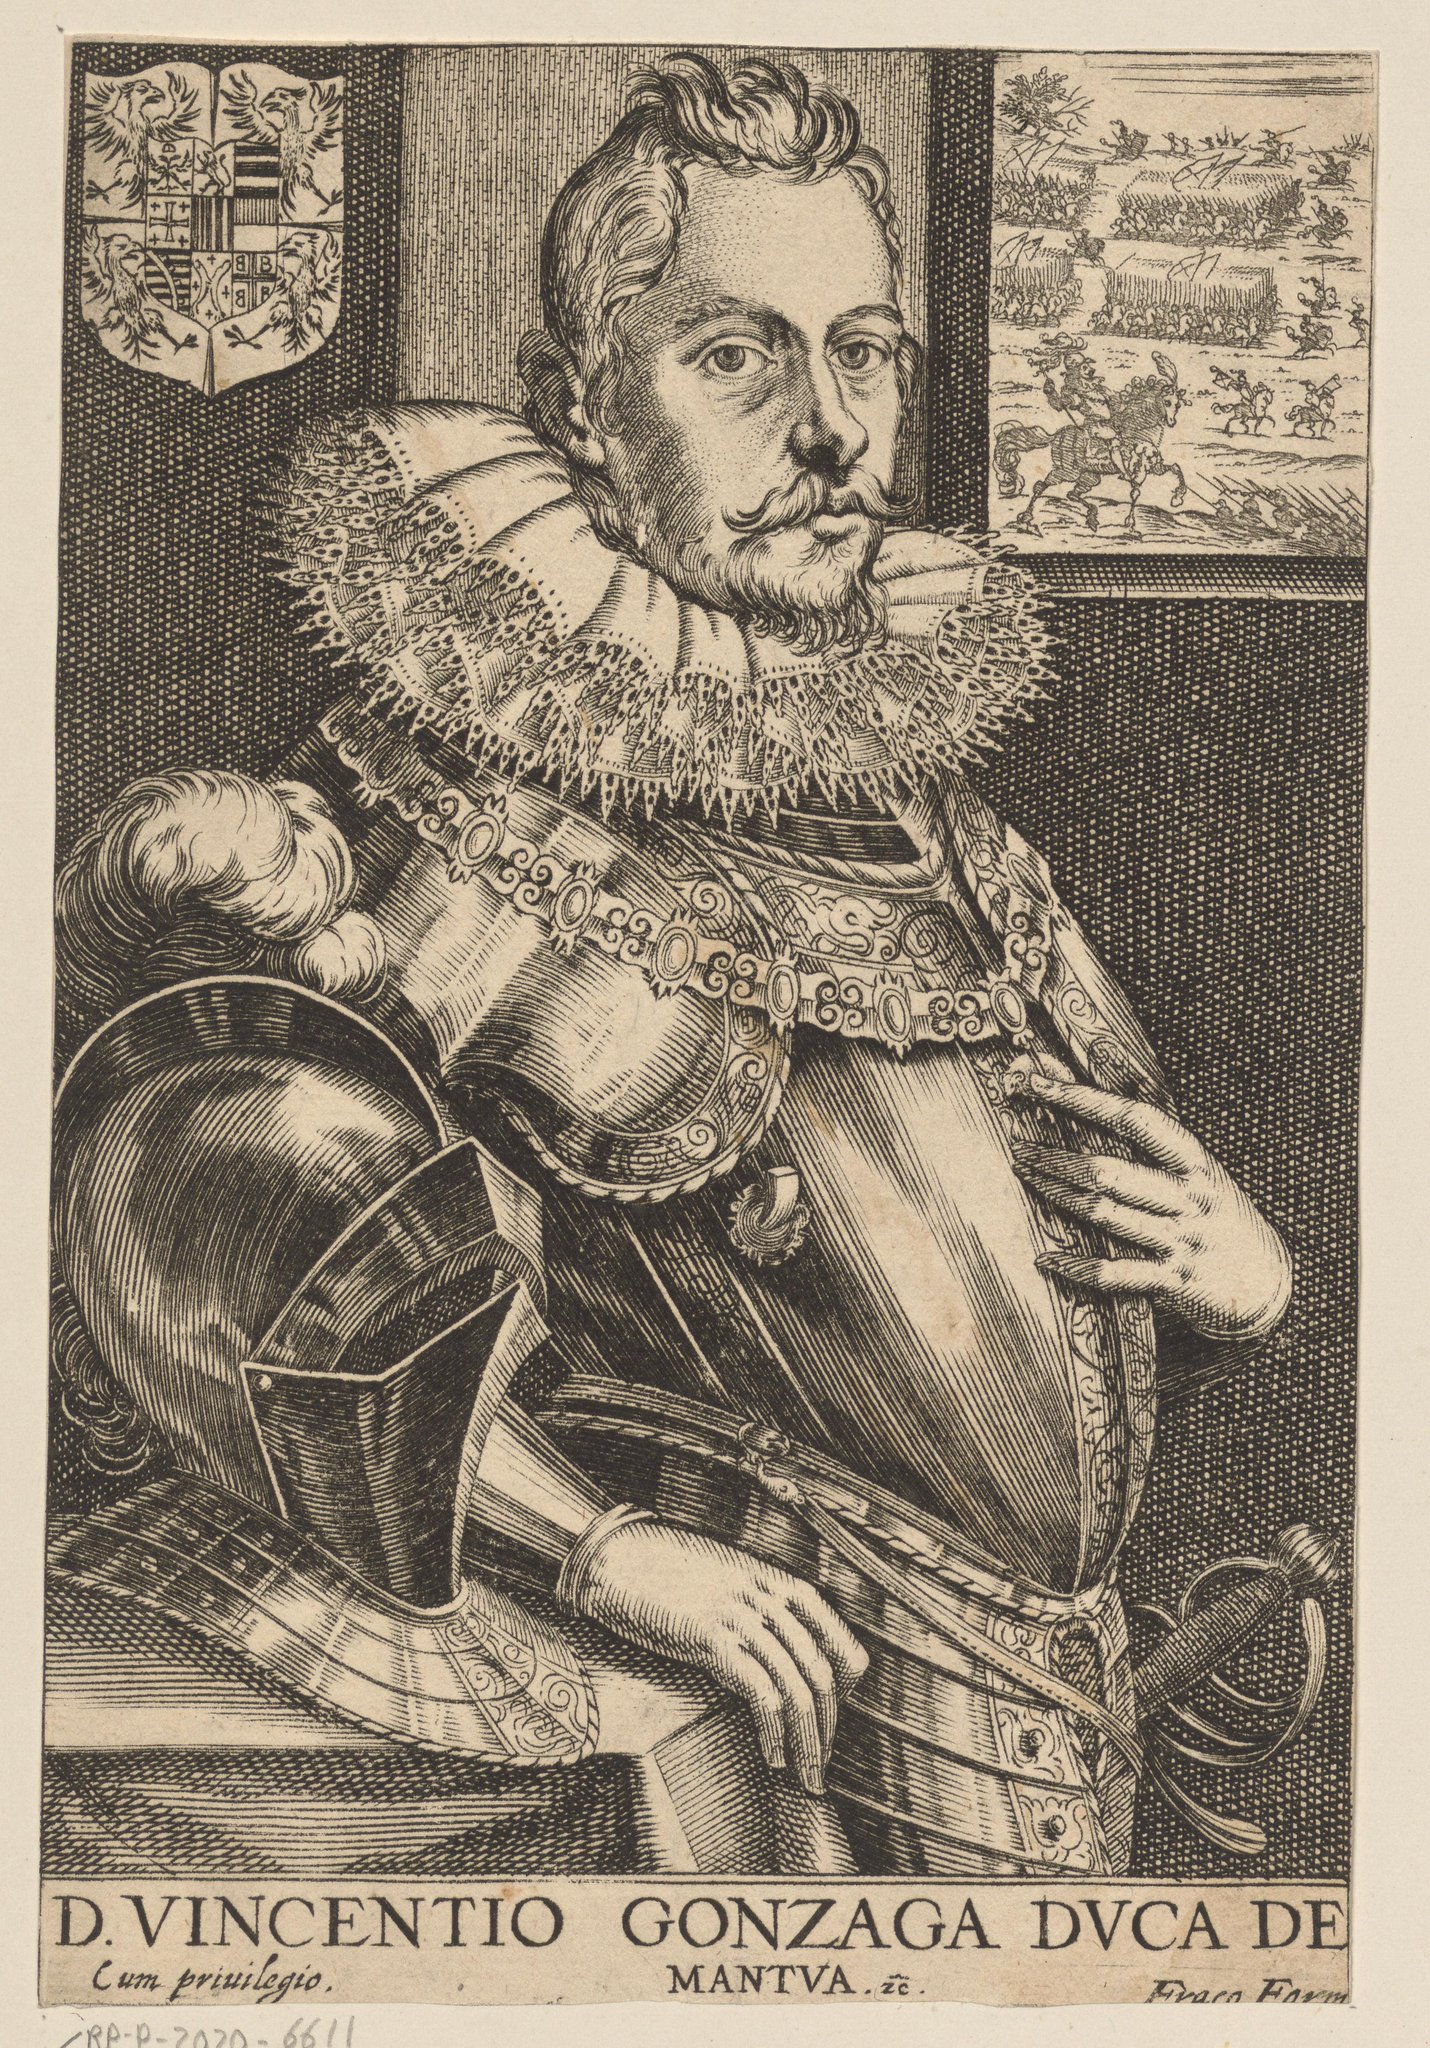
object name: print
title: Portret van Vincenzo Gonzaga, hertog van Mantua en Monferrato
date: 1622-1722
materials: paper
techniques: engraving, etching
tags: vincenzo gonzaga (hertog van mantua en monferrato), commander-in-chief, general, marshal, historical persons